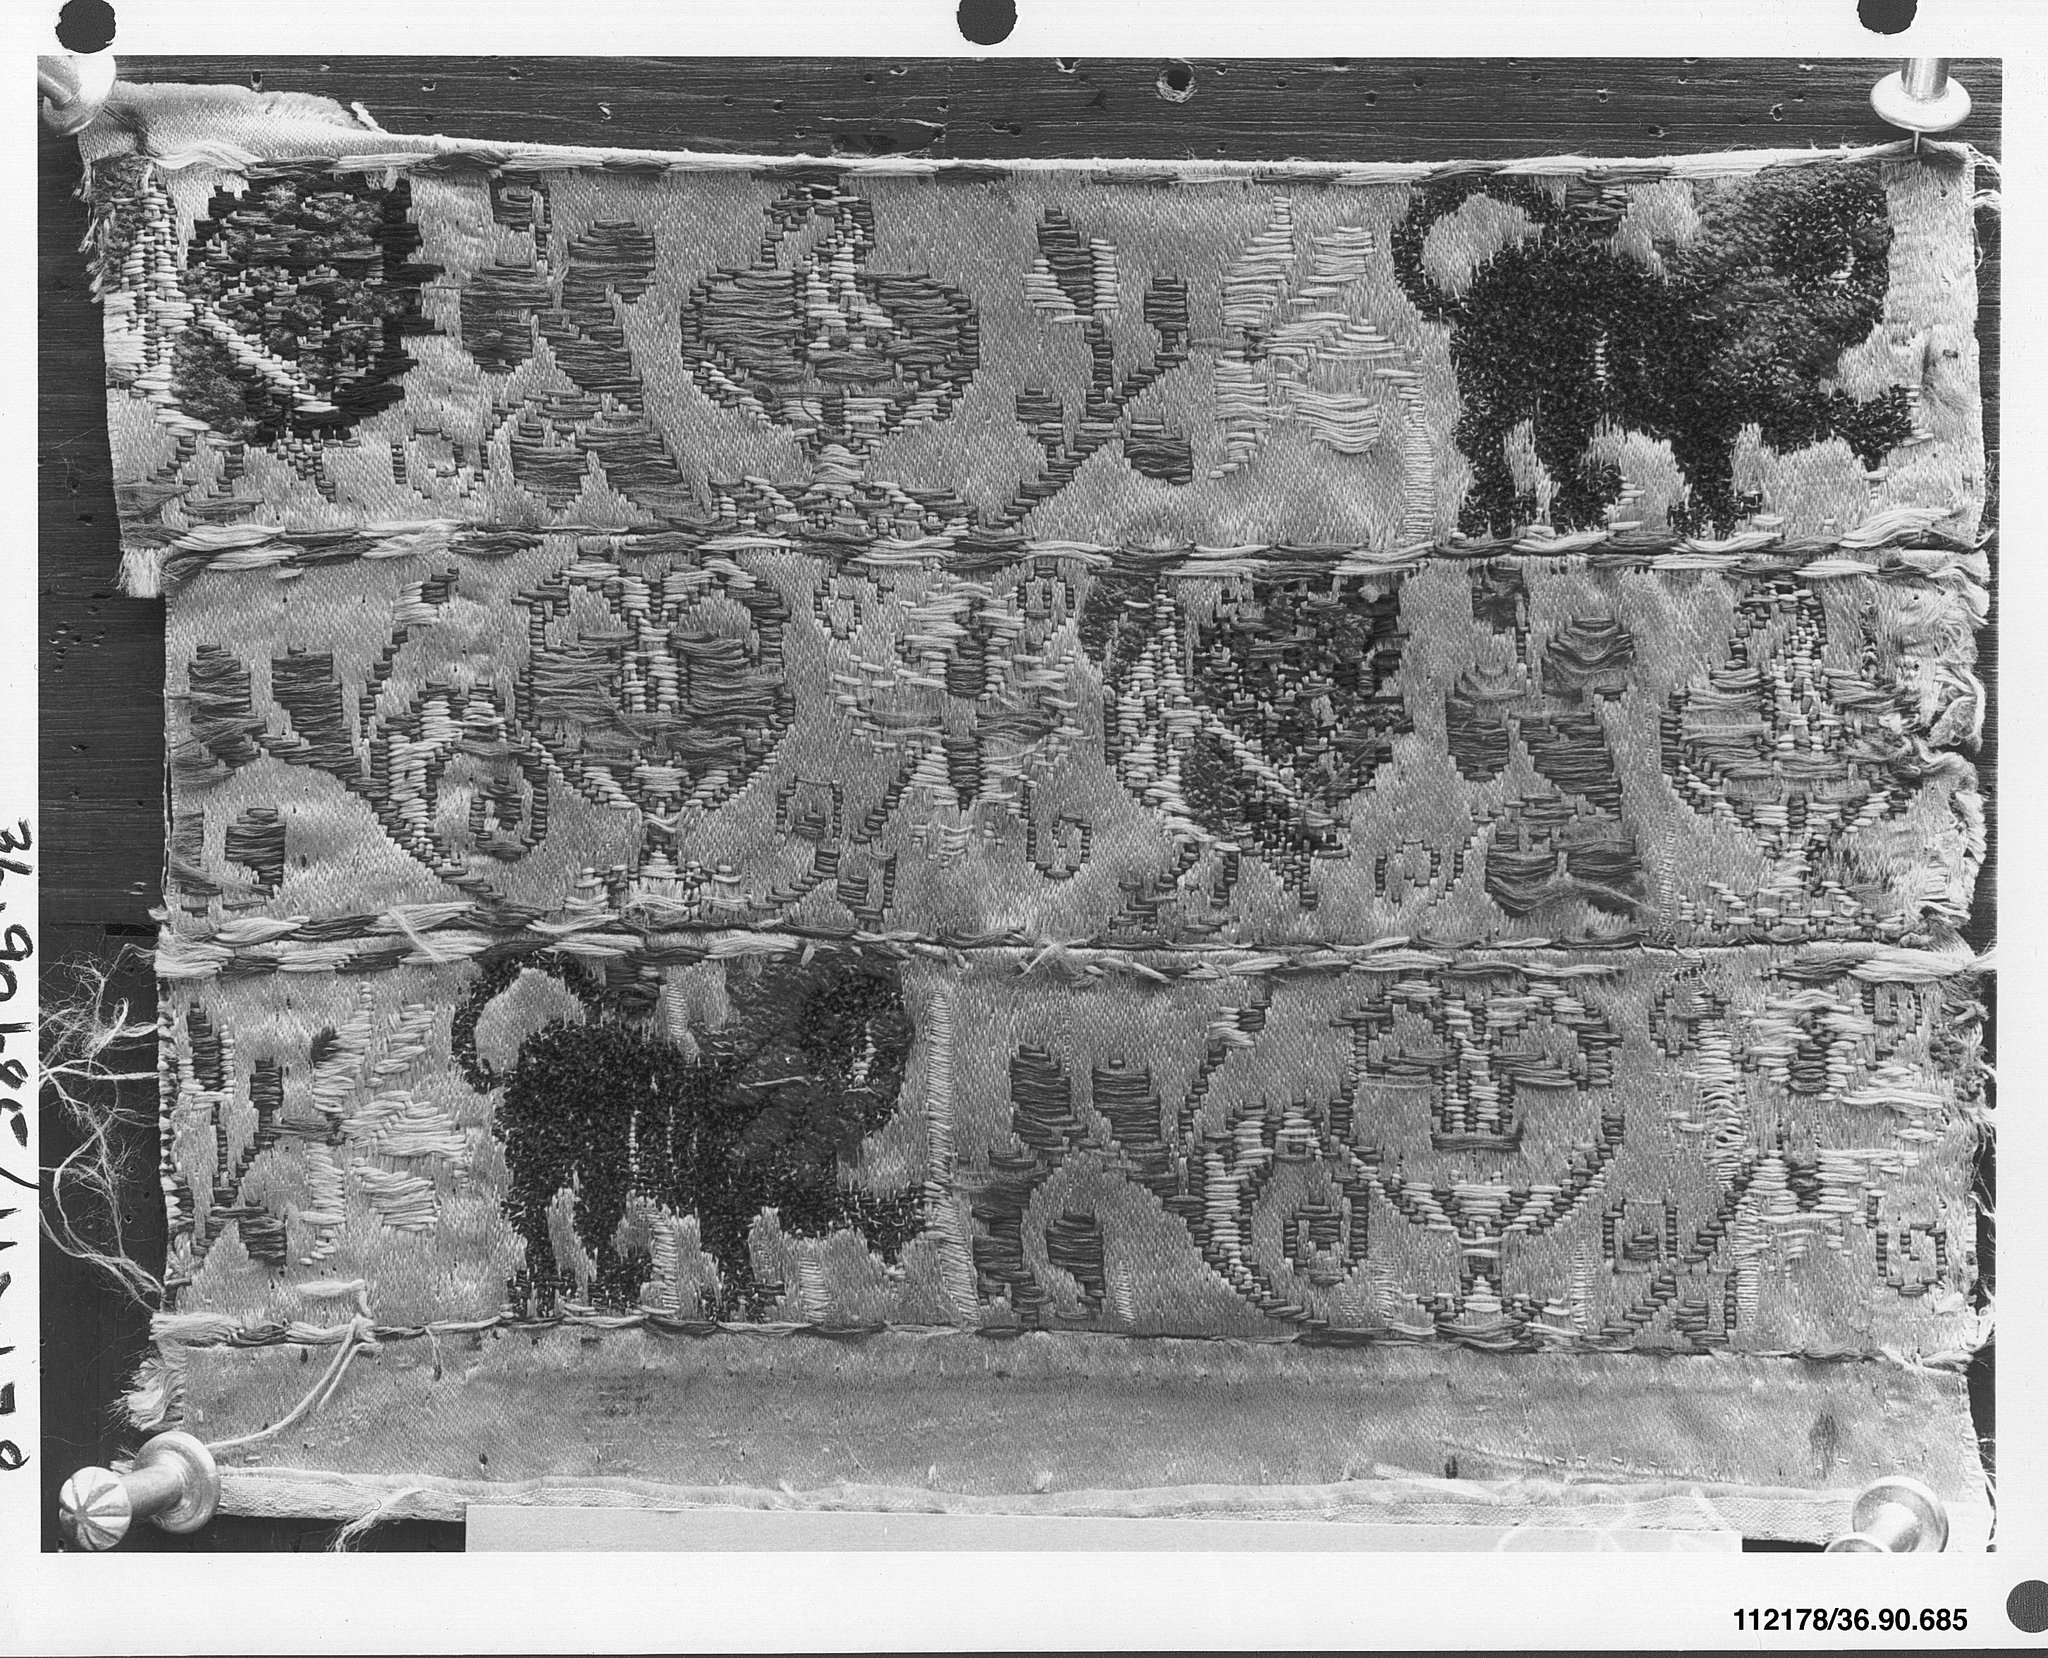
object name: fragment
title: Fragments (3)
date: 1601-1700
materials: silk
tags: animals,flowers